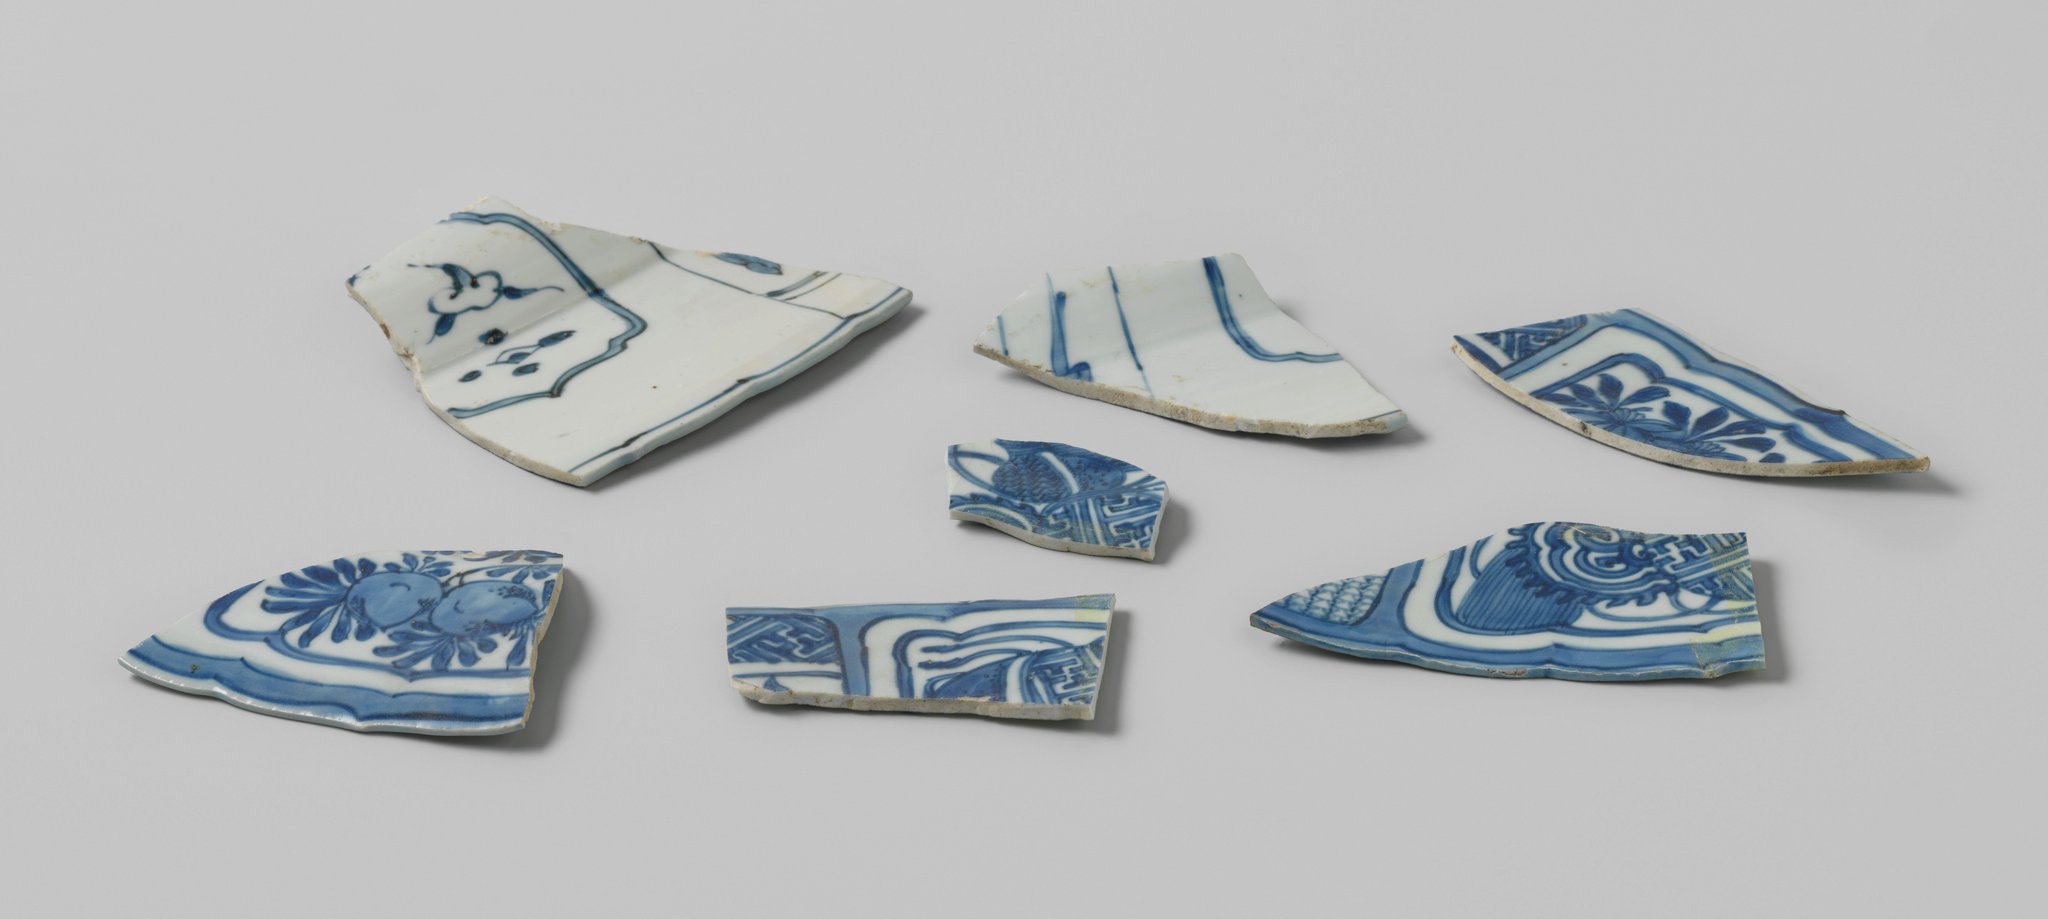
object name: sherd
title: Scherven van borden uit V.O.C.-schip de 'Witte Leeuw'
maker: Anonymous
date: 1613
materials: bone china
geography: jingdezhen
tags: verenigde oostindische compagnie, sint-helena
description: Scherven van borden uit V.O.C.-schip de 'Witte Leeuw'.